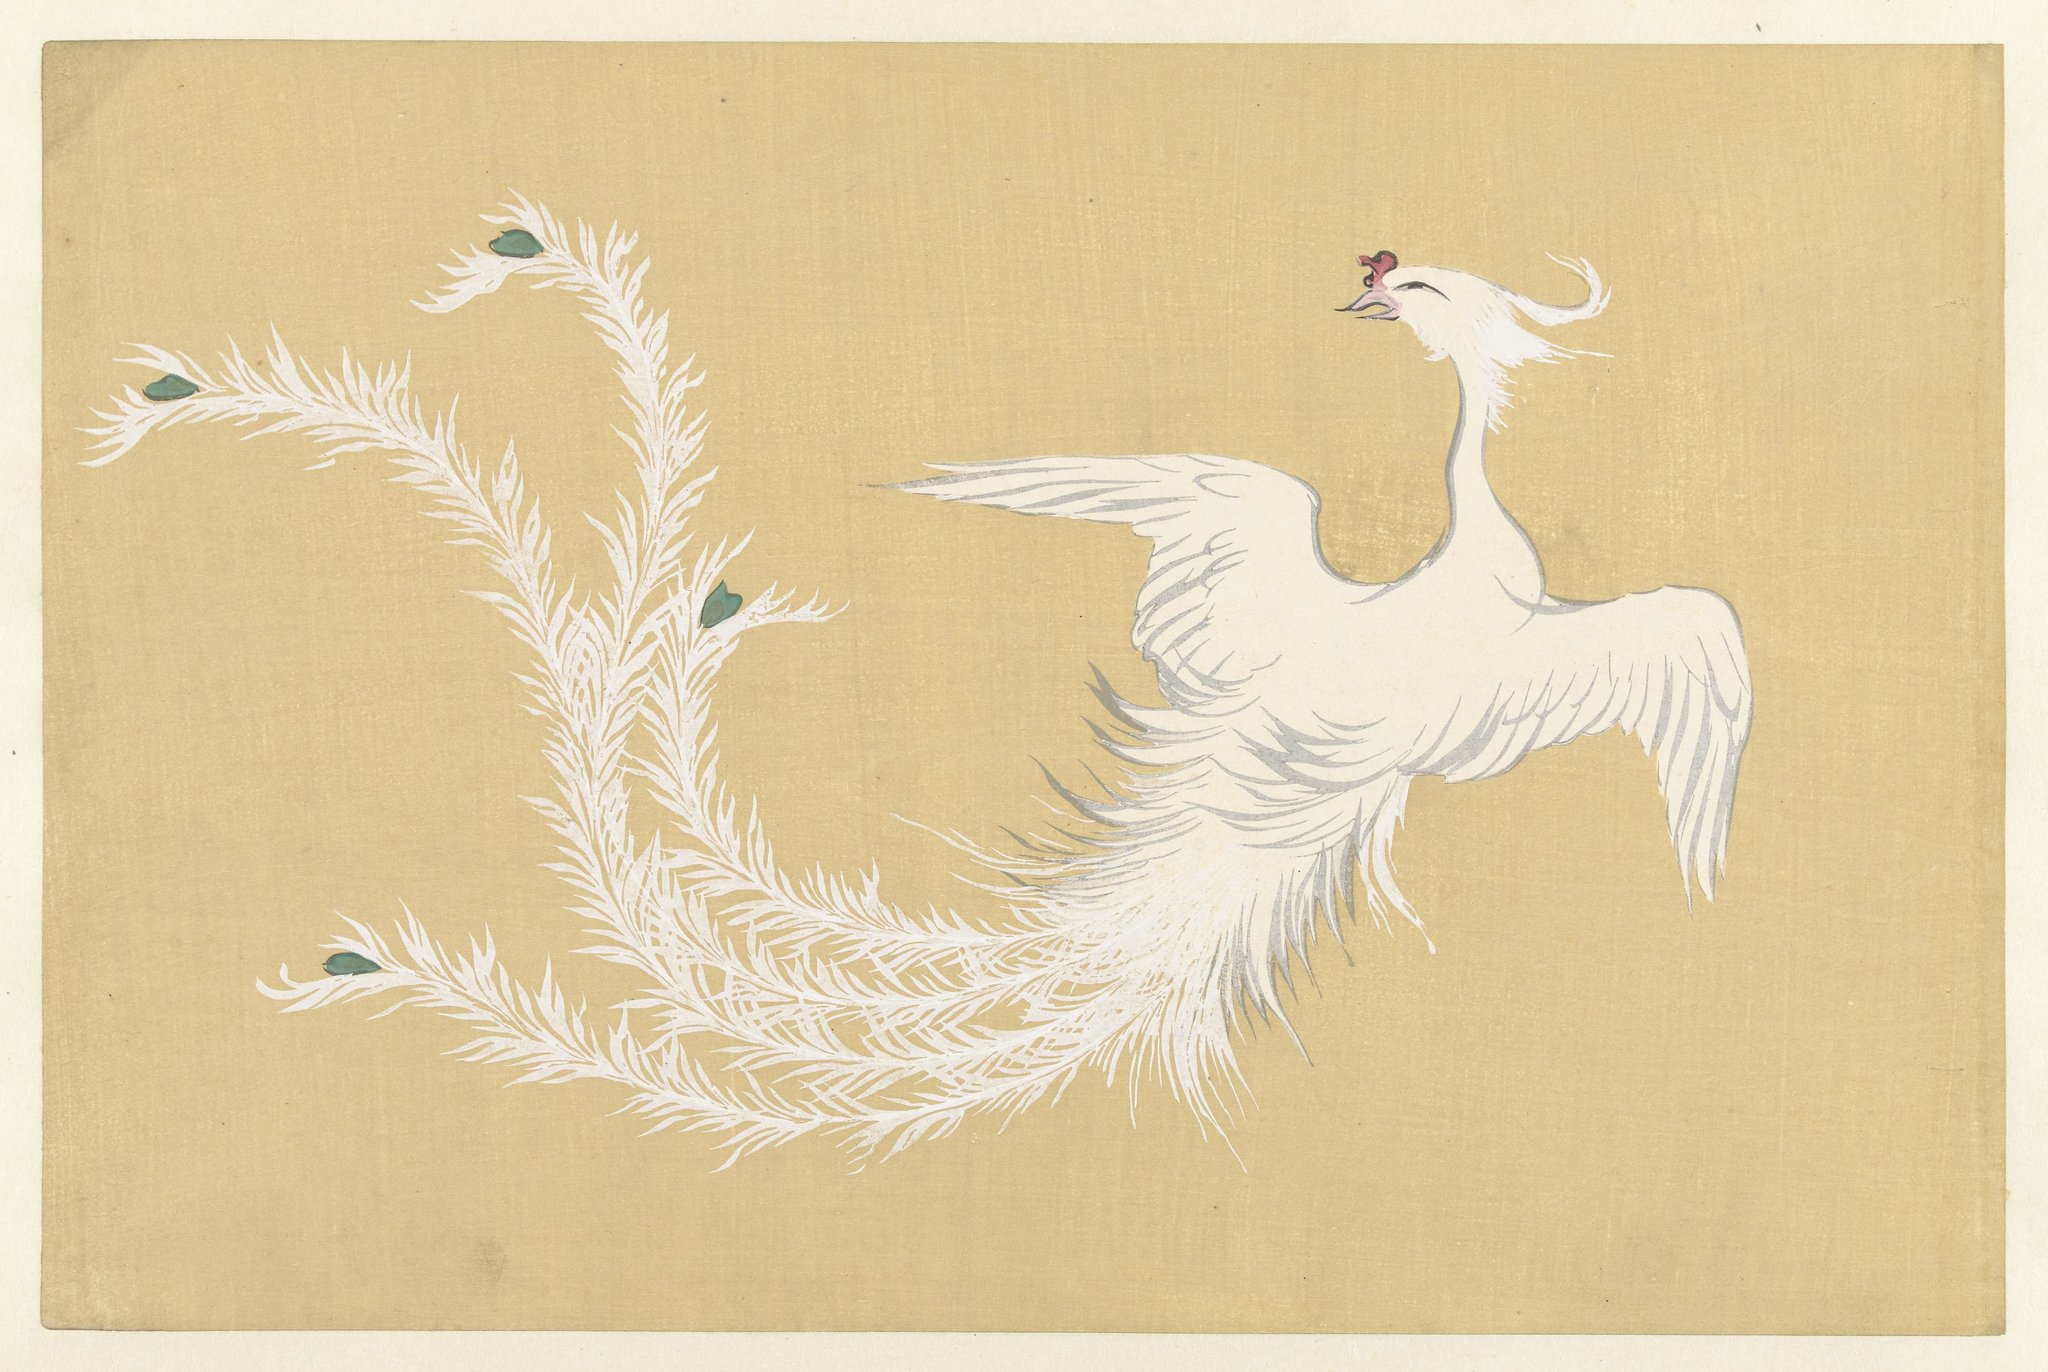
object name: print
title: Bloemen van honderd werelden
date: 1909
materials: paper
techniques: woodcut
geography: kyoto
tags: fabulous animals ~ birds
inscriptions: collector's mark: Lugt 2228, collector's mark: Lugt 2760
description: Witte feniks met lange staart; tegen beige achtergrond. Prent uit deel 1 van het album Momoyogusa